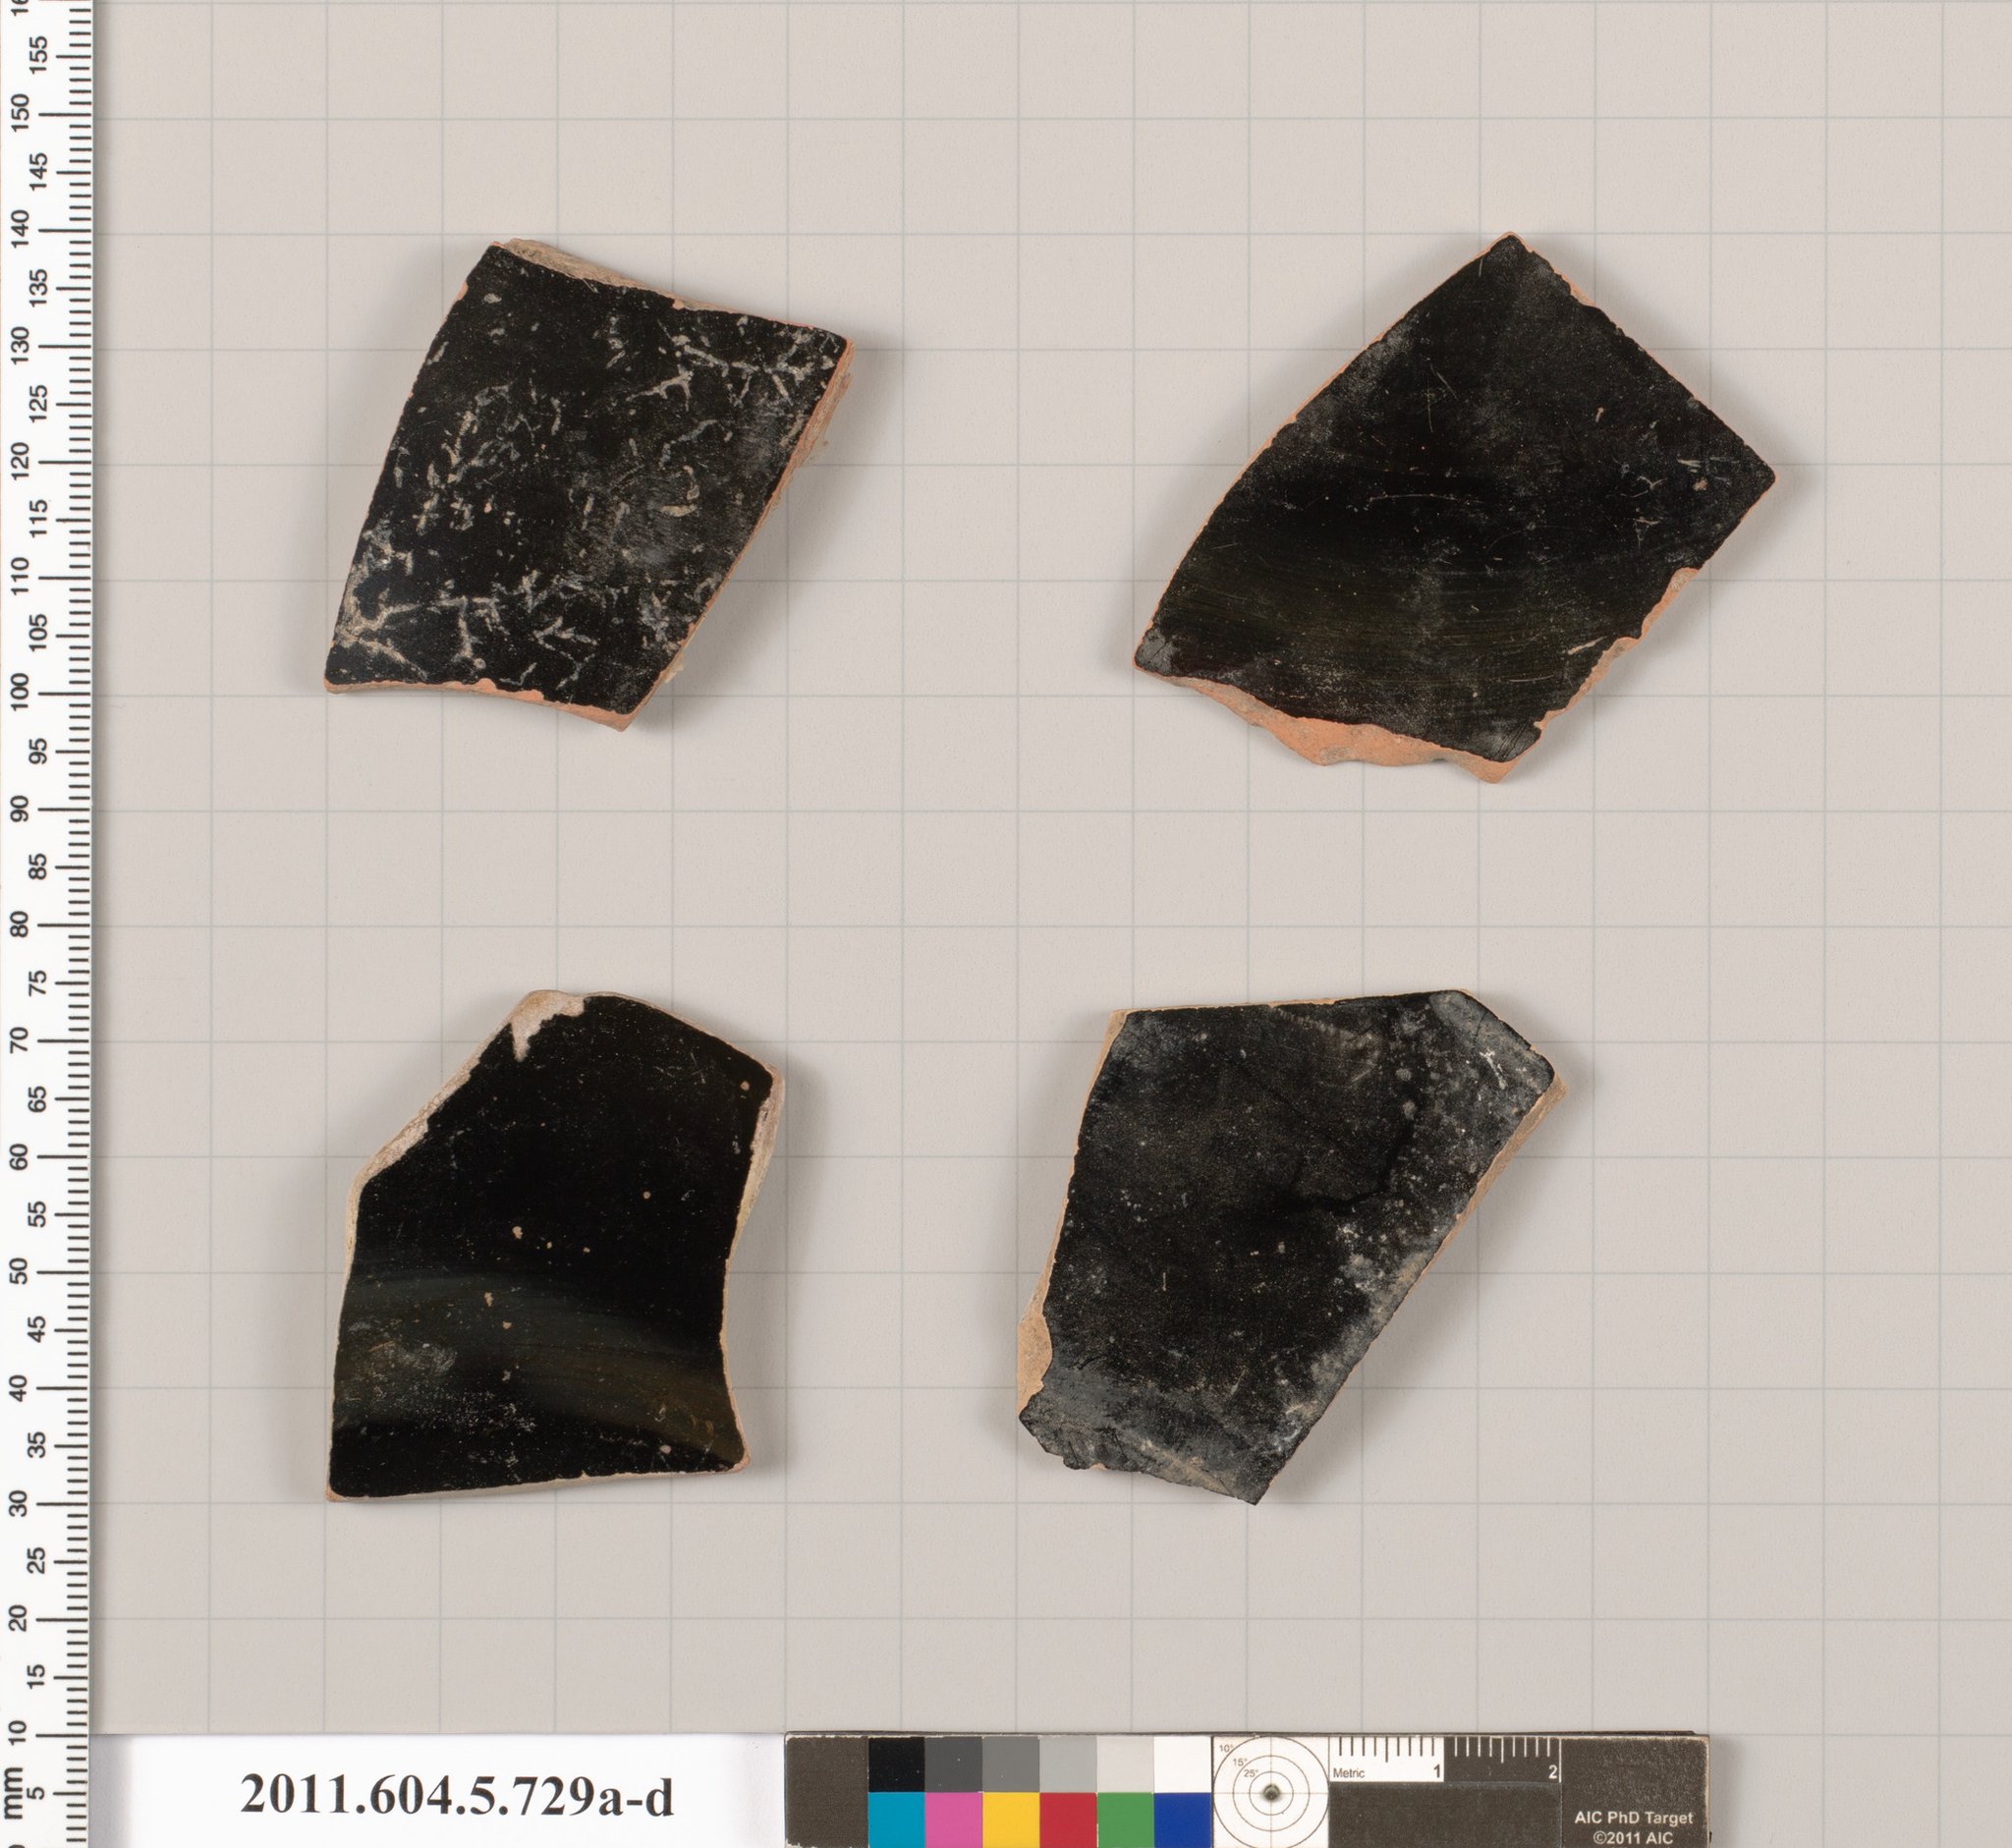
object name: kylix fragment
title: Terracotta fragments of kylikes (drinking cups)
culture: greek, attic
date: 600-401 BCE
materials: terracotta